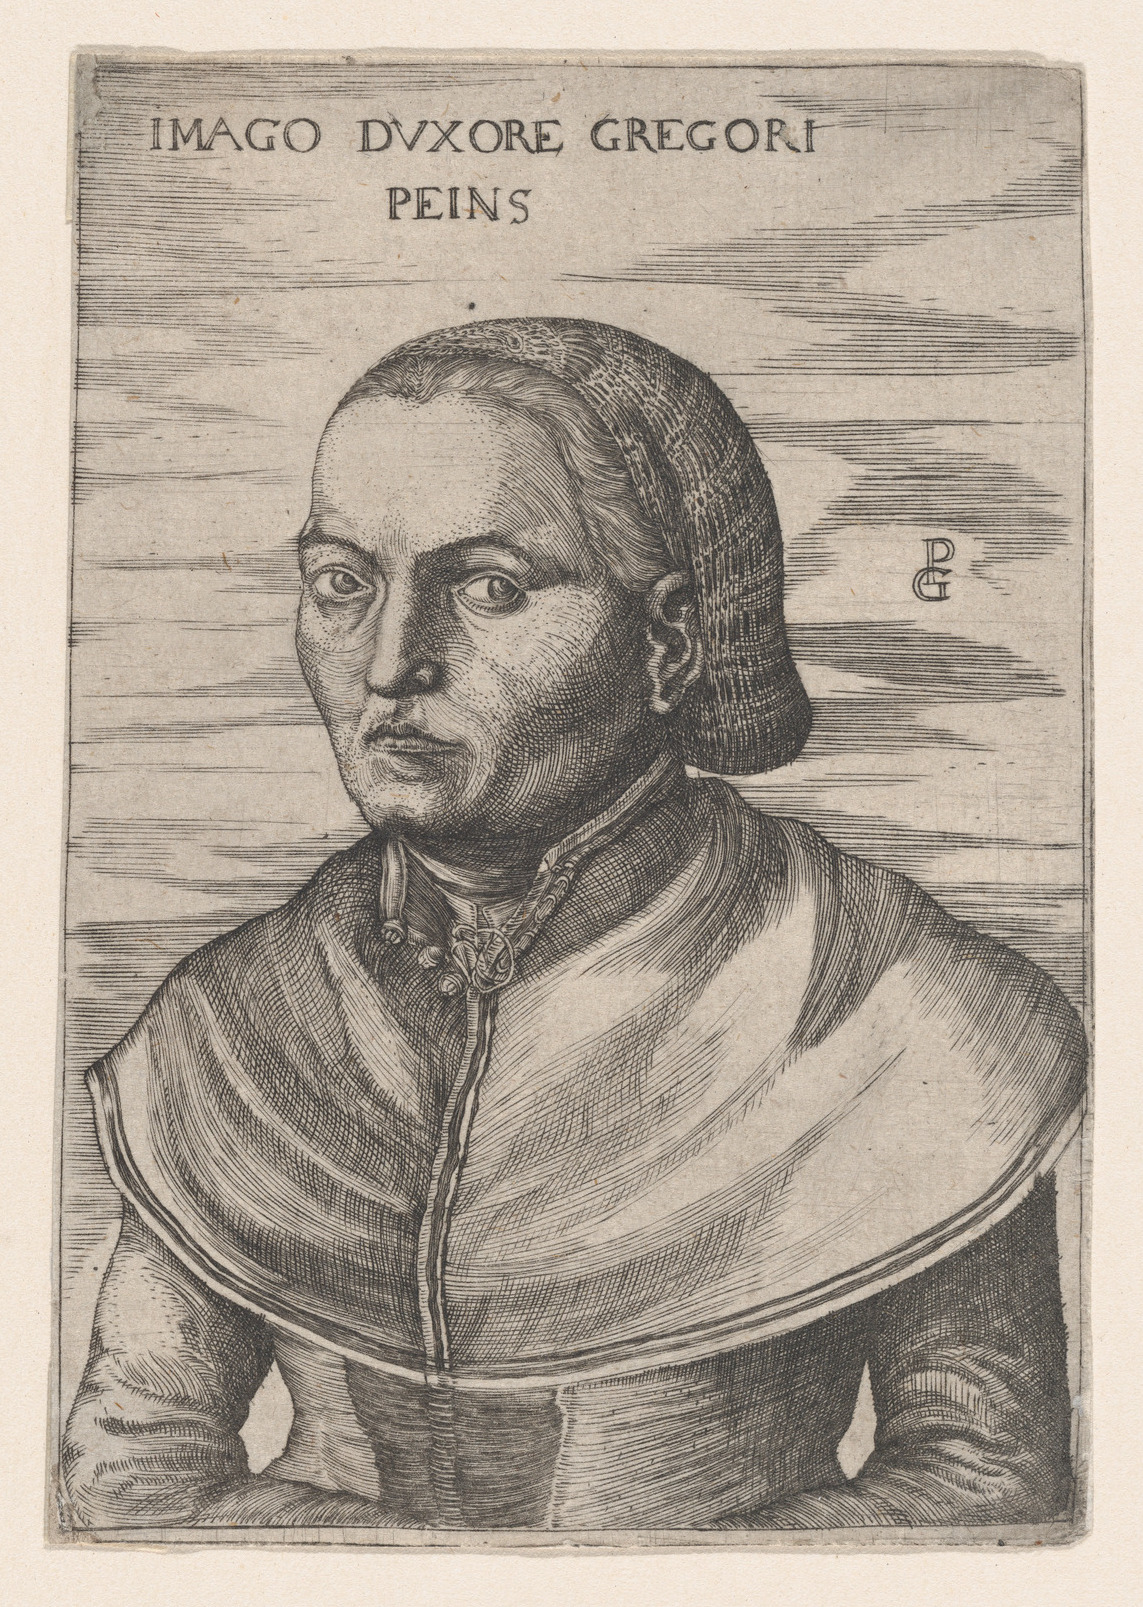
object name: print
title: Portrait of the Wife of Georg Pencz (Imago Duxore Gregori Peins)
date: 1520-1600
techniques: engraving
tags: portraits,women